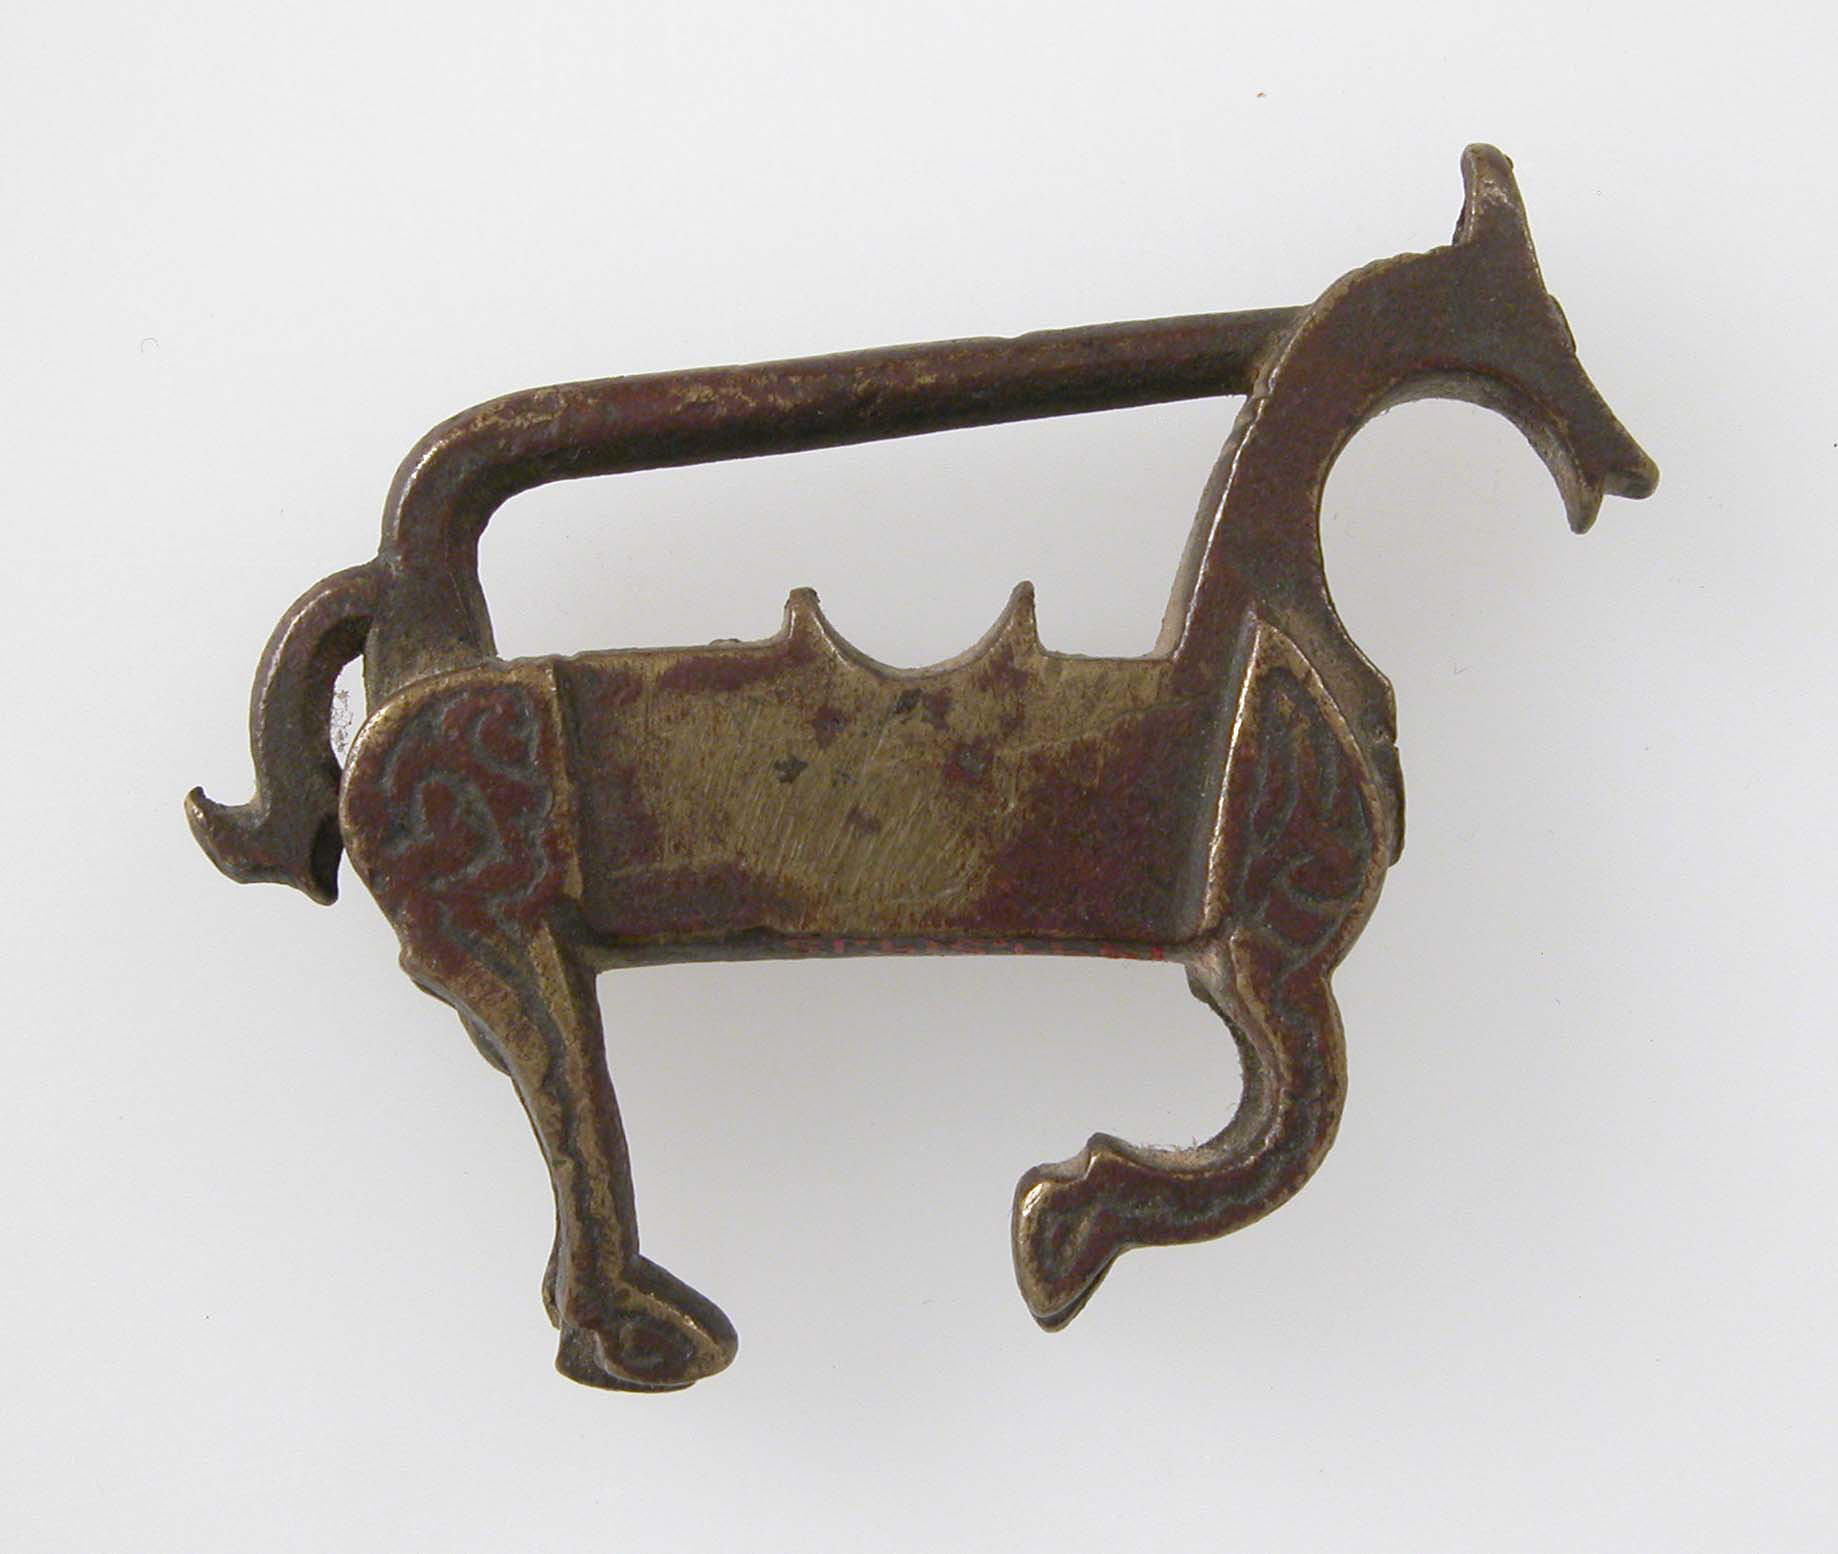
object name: lock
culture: byzantine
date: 1001-1100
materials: copper alloy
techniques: casting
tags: horses